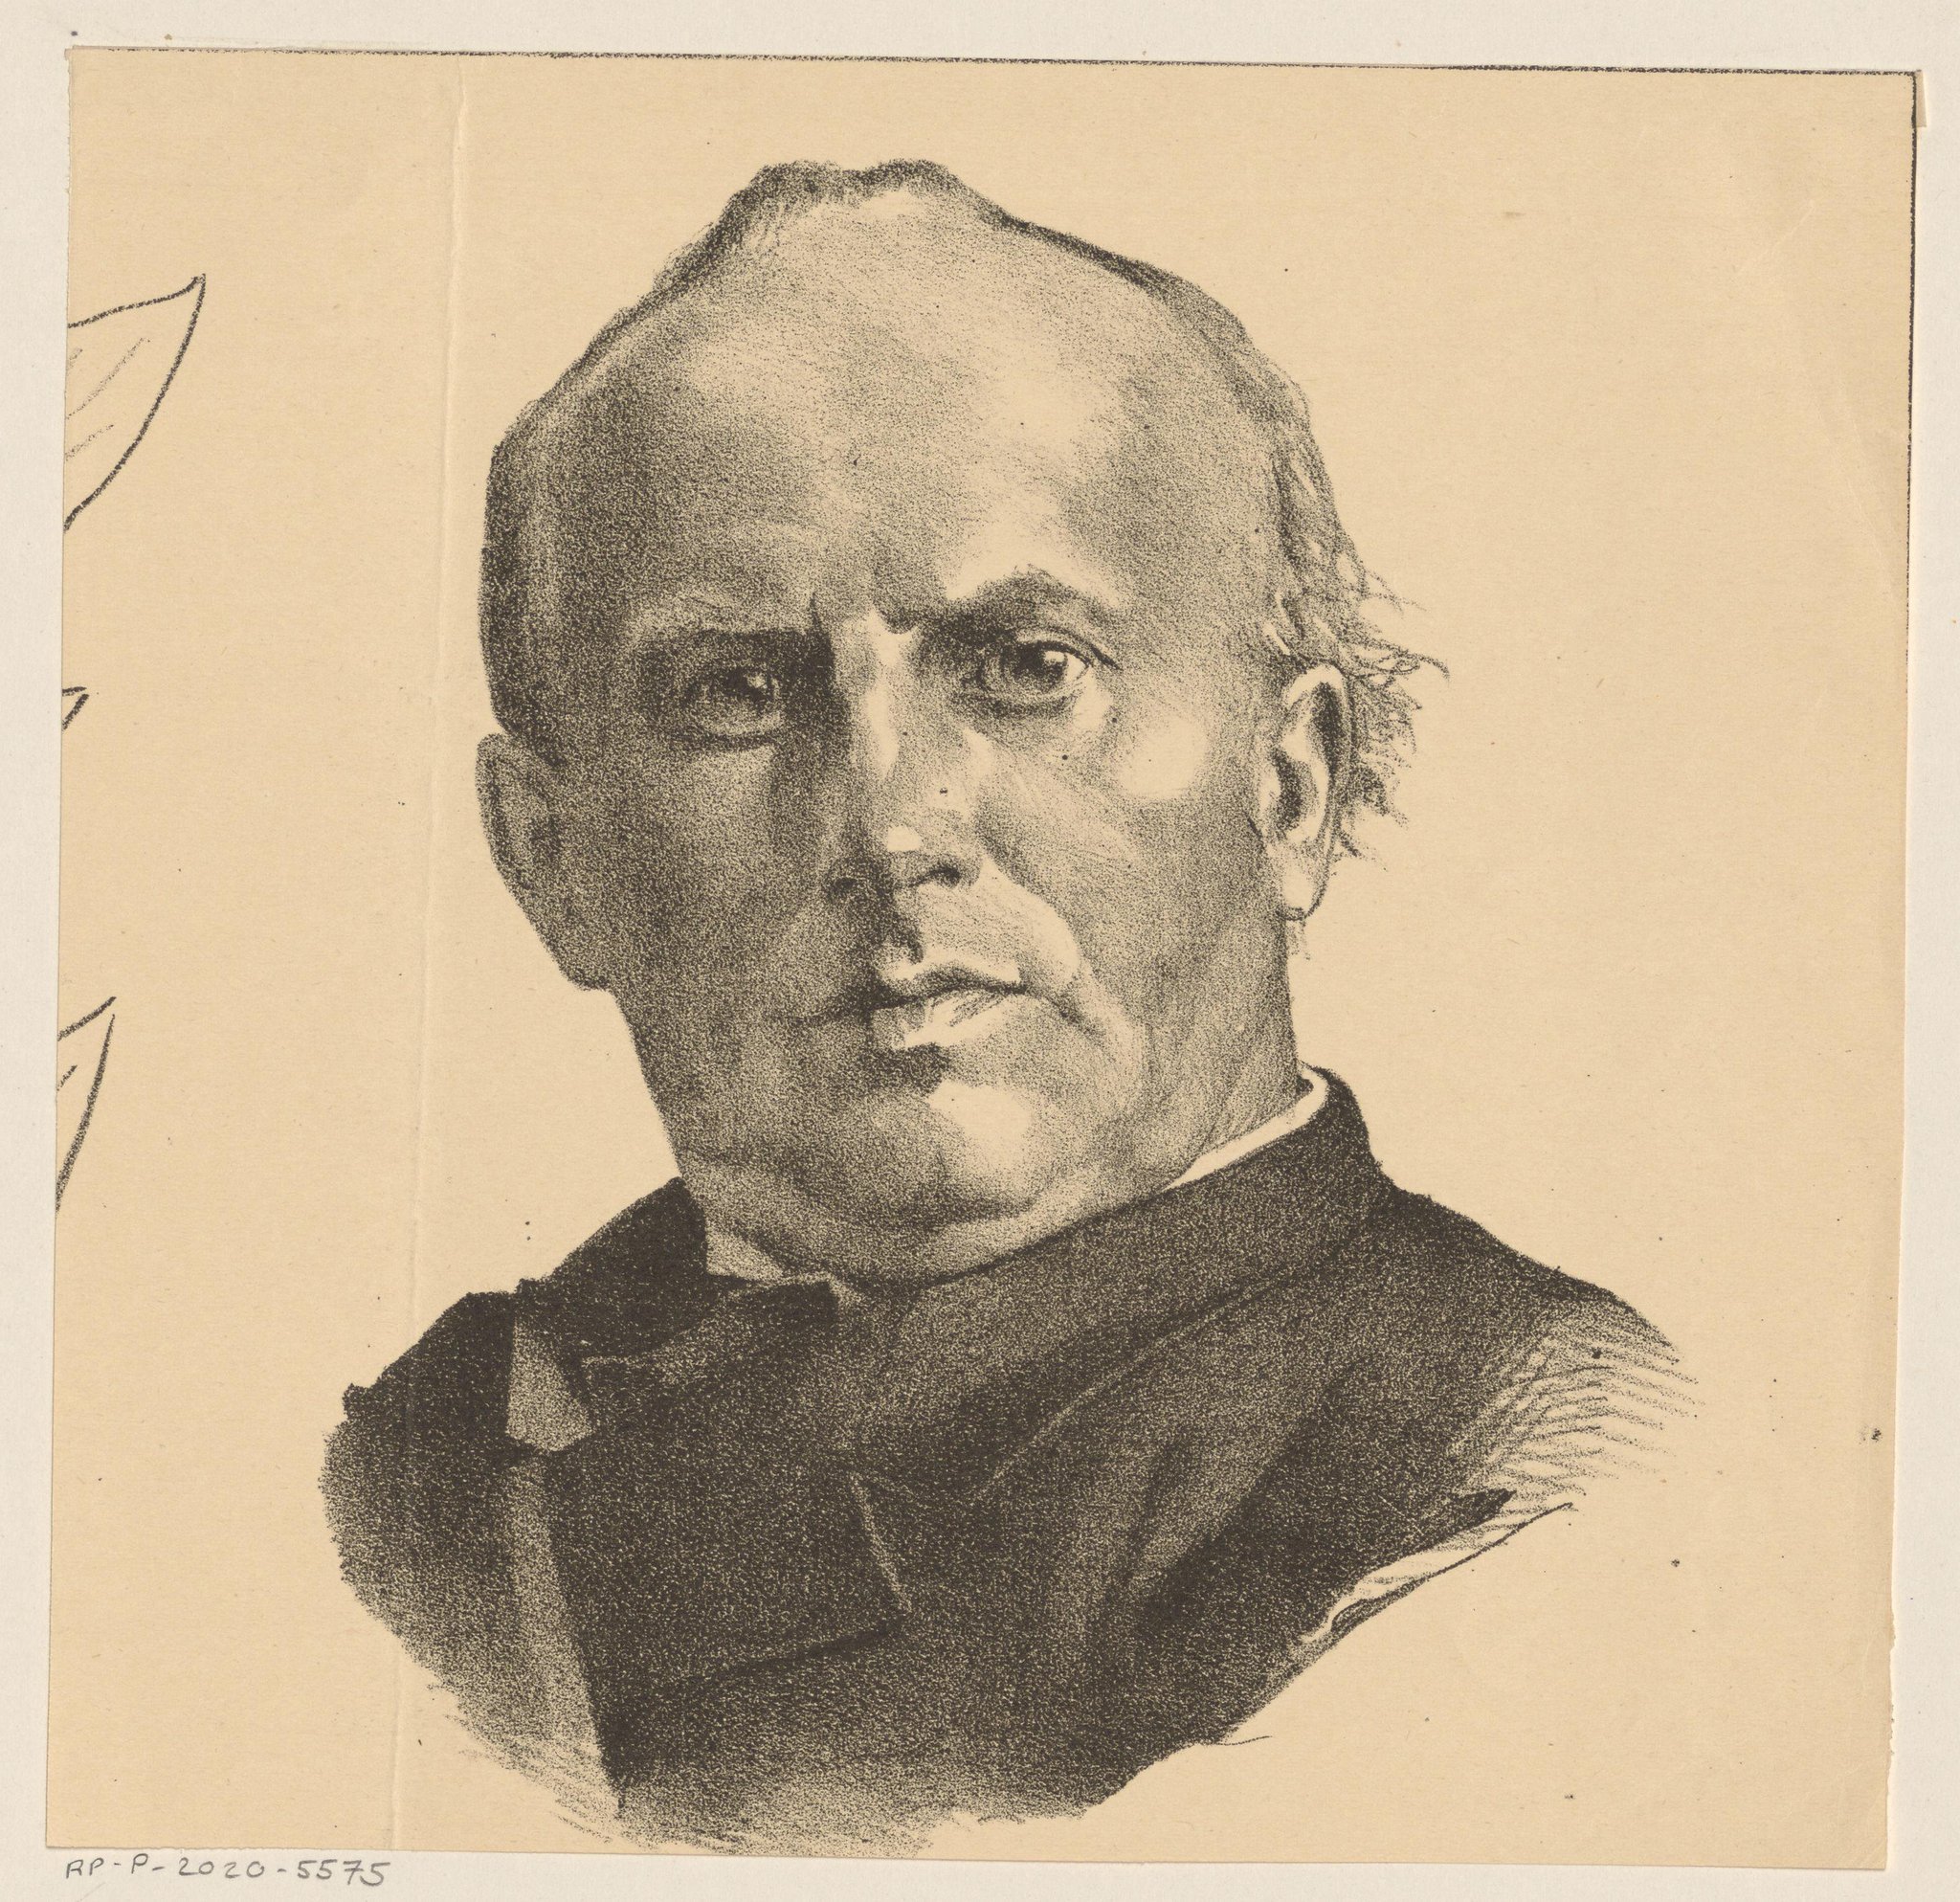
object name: print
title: Portret van Johannes Theodoor Buys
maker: Anonymous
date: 1860-1899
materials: paper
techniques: lithograph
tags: warmond, historical persons, lawyer, attorney at law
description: Portret afkomstig uit een grotere prent.